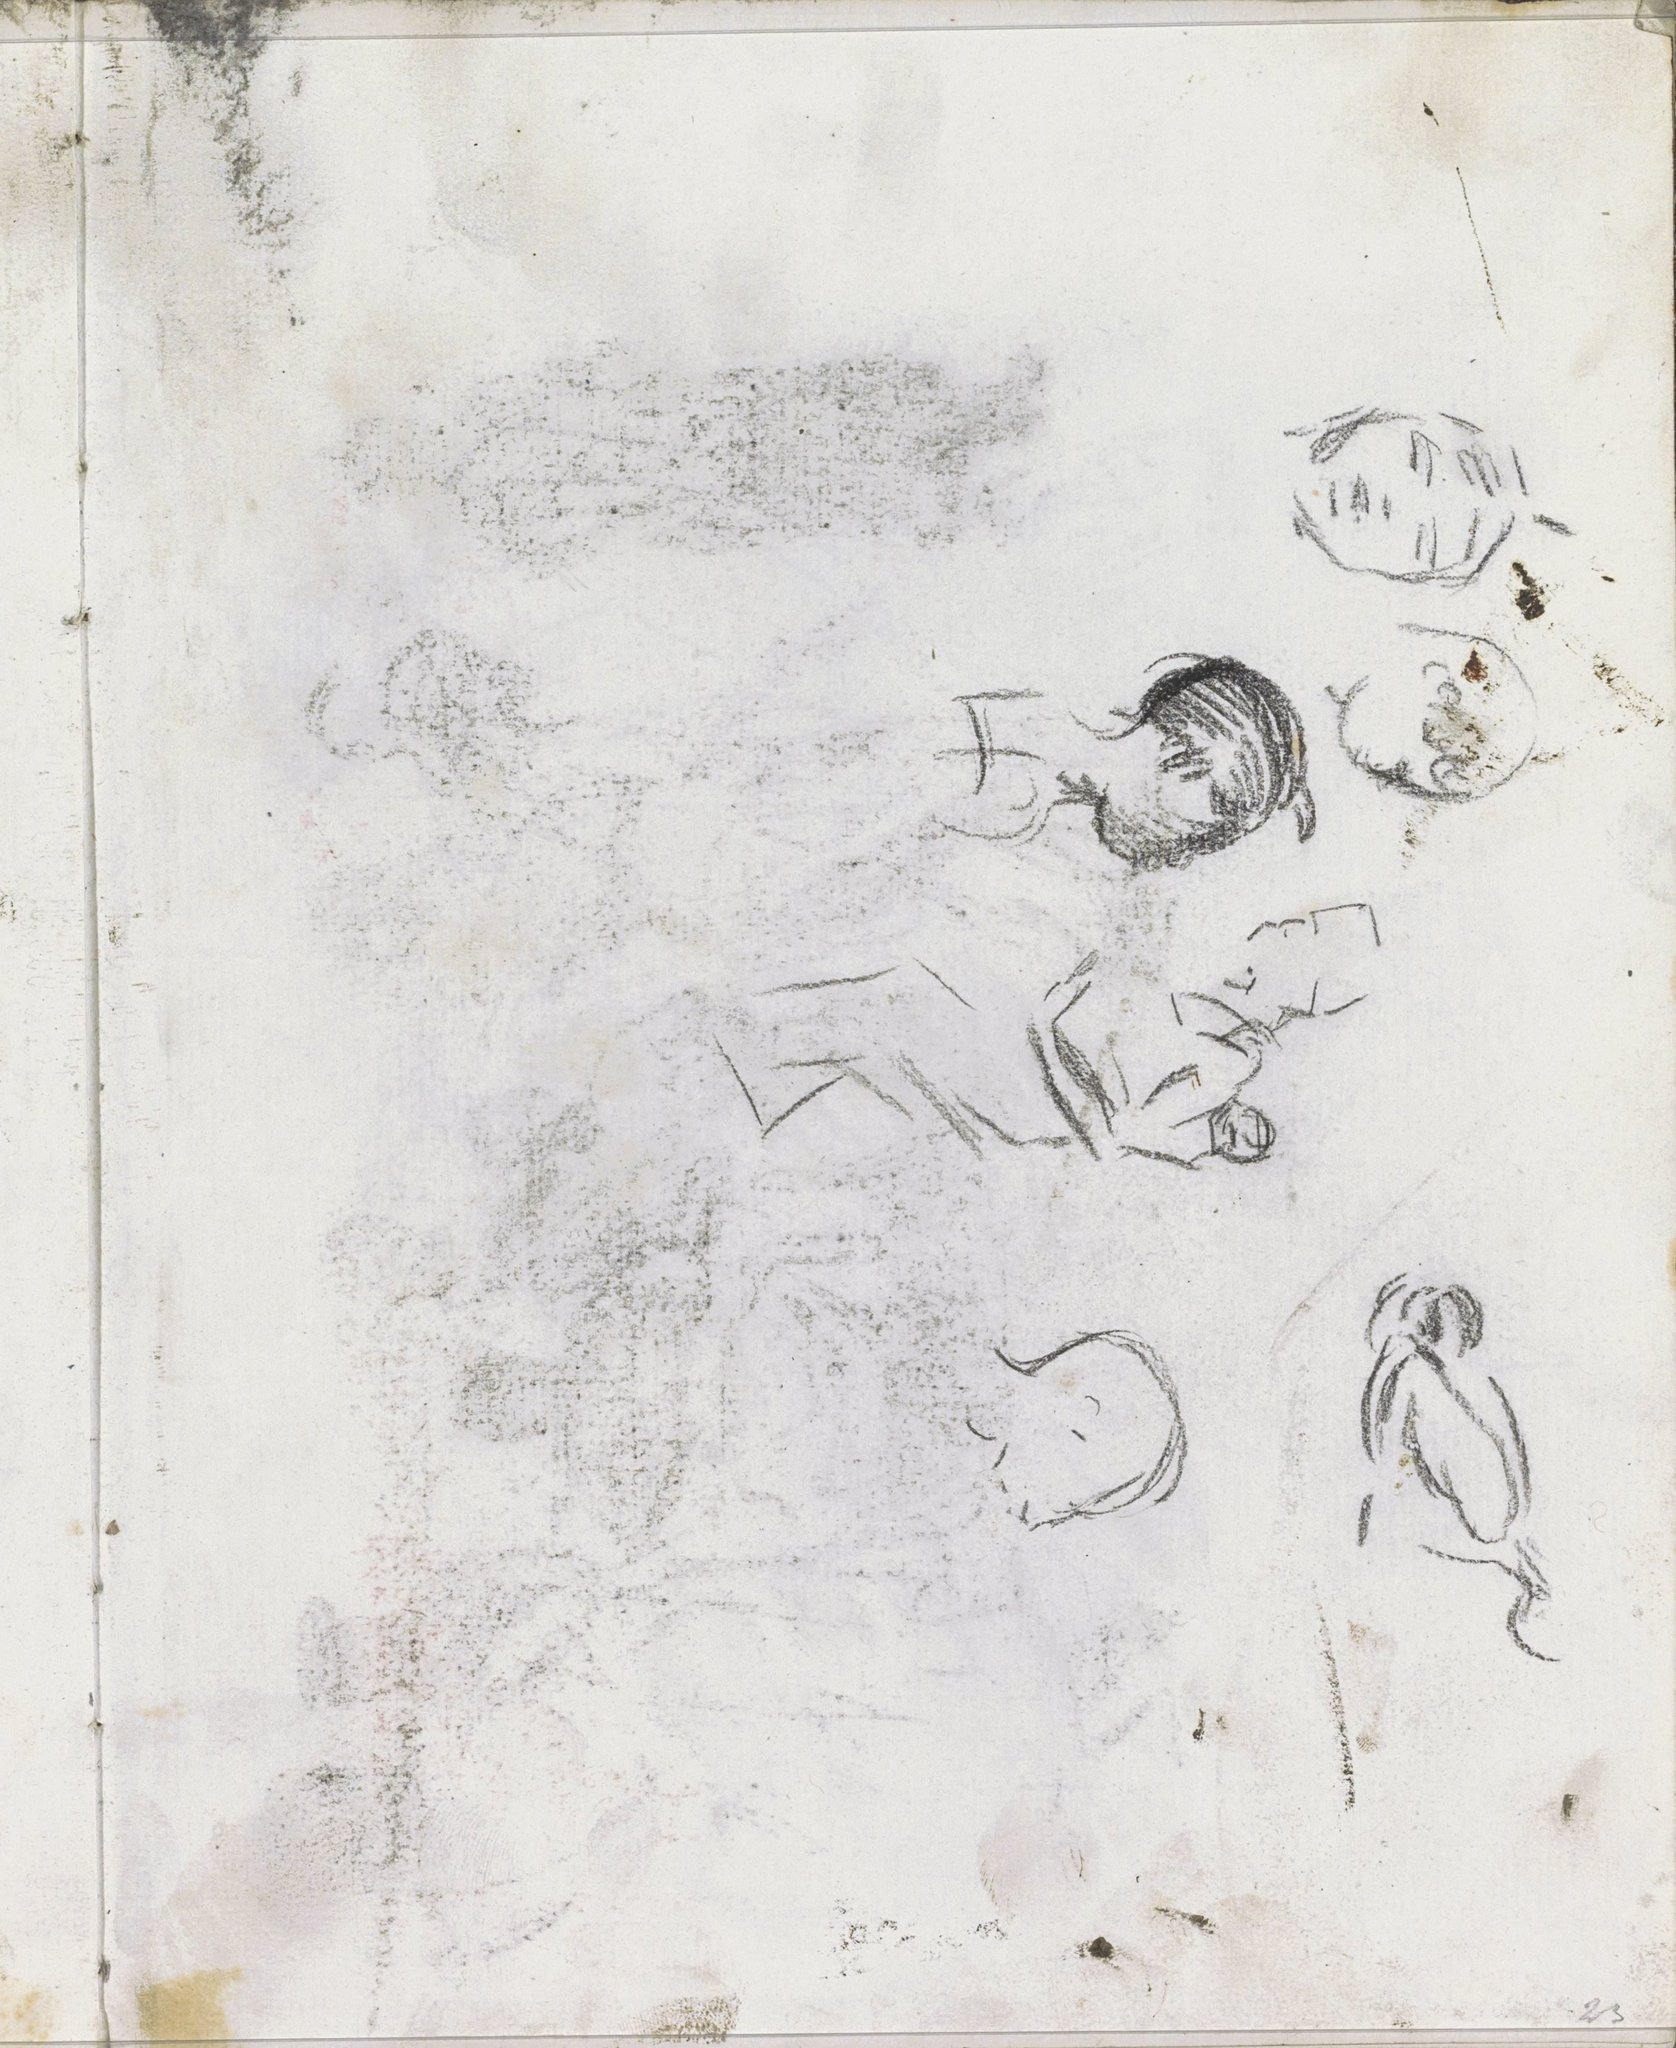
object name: sketchbook leaf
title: Studieblad met hoofden en een vrouw met kind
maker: isaac israels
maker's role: draughtsman, painter, print maker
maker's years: 1865-1934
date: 1875-1934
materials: chalk, paper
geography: the hague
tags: head (human), mother and baby or young child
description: Blad 23 recto uit schetsboek XIII met 25 bladen.